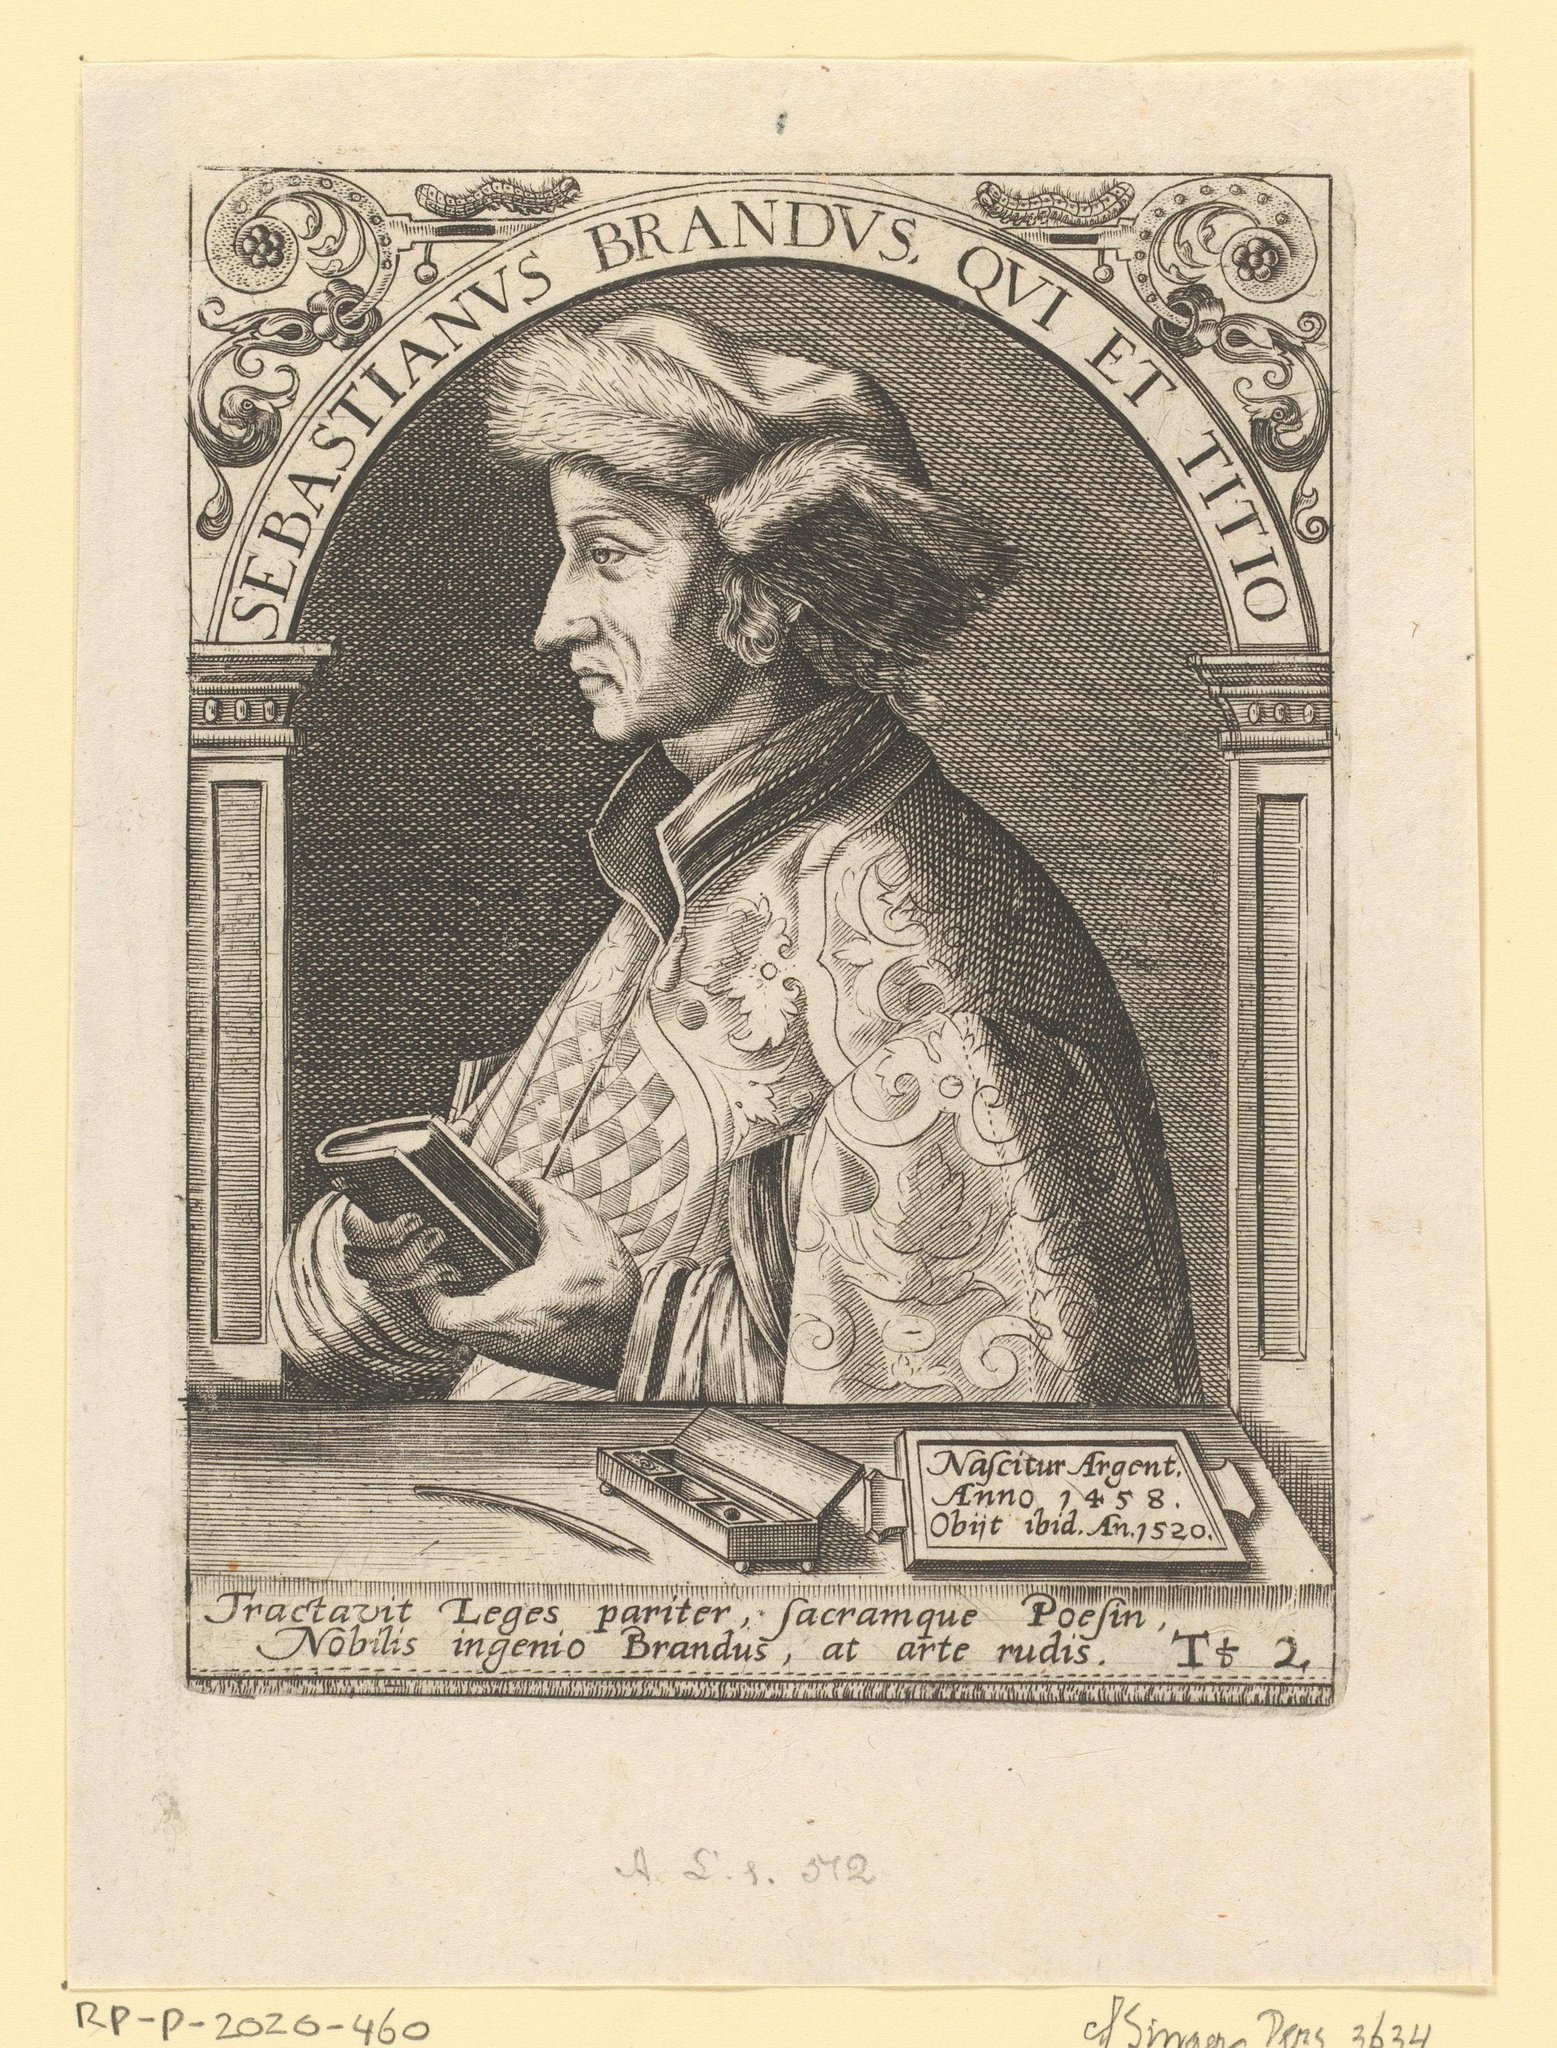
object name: book illustration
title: Sebastianus Brandus, qui et titio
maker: jean jacques boissard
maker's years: 1528-1598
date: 1650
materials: paper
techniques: engraving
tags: sebastian brant, historical persons, lawyer, attorney at law, portrait of a writer, writer, poet, author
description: Prent gebruikt in: Boissard, Jean Jacques. Bibliotheca chalcographica. 8 dln. Frankfurt am Main: Johannes Ammon, 1650-1652. Ook gebruikt in latere edities. Eerdere staat van prent verschenen in: Boissard, Jean Jacques. Icones quinquaginta virorum illustrium doctrina & eruditione praestantium ad vivum effictae. 4 dln. Frankfurt am Main: s.n., 1597-1599. Mogelijk ook gebruikt in latere edities.